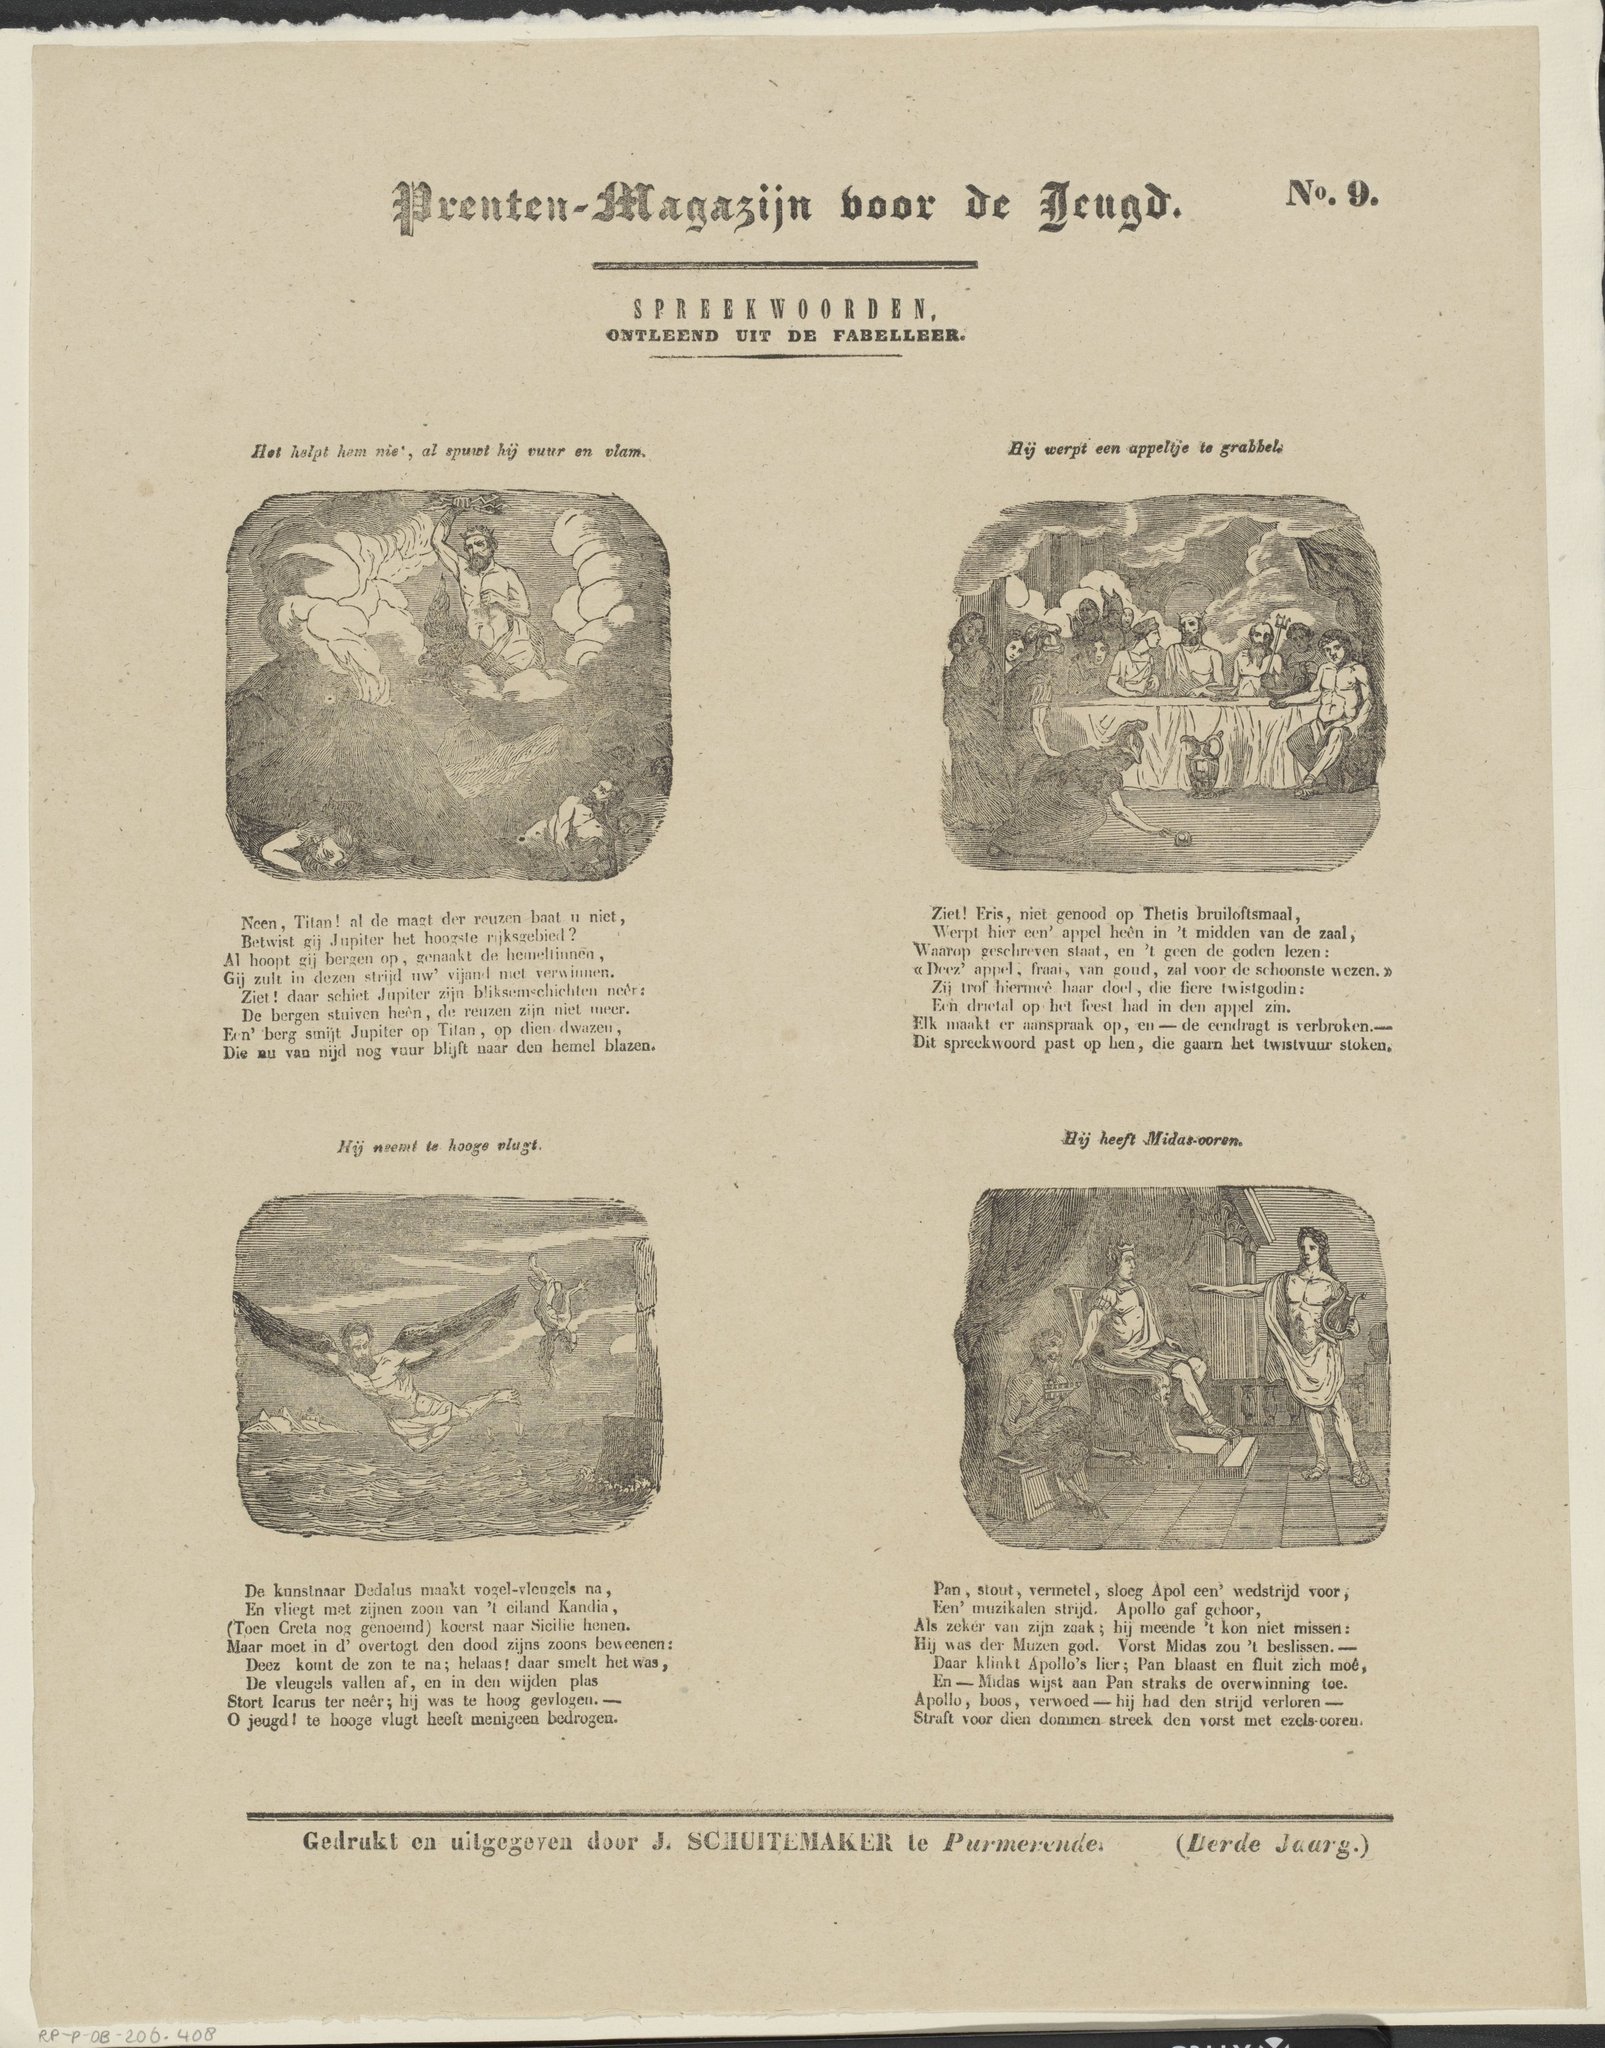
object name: print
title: Spreekwoorden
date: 1844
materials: paper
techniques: letterpress printing, engraving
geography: purmerend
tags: war of the titans against jupiter and allies: titanomachy, (story of) icarus, son of daedalus, proverbs, sayings, etc., eris throws the golden apple, classical mythology and ancient history, midas given ass's ears: apollo gives midas ass's ears as punishment for preferring pan in the musical contest between apollo and pan (ovid, metamorphoses xi 174)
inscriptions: collector's mark: Lugt 2760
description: Blad met 4 verbeeldingen van spreekwoorden, gebaseerd op mythologische verhalen. Boven elke voorstelling een titel en onder elke voorstelling een achtregelig vers. Genummerd rechtsboven: No. 9.